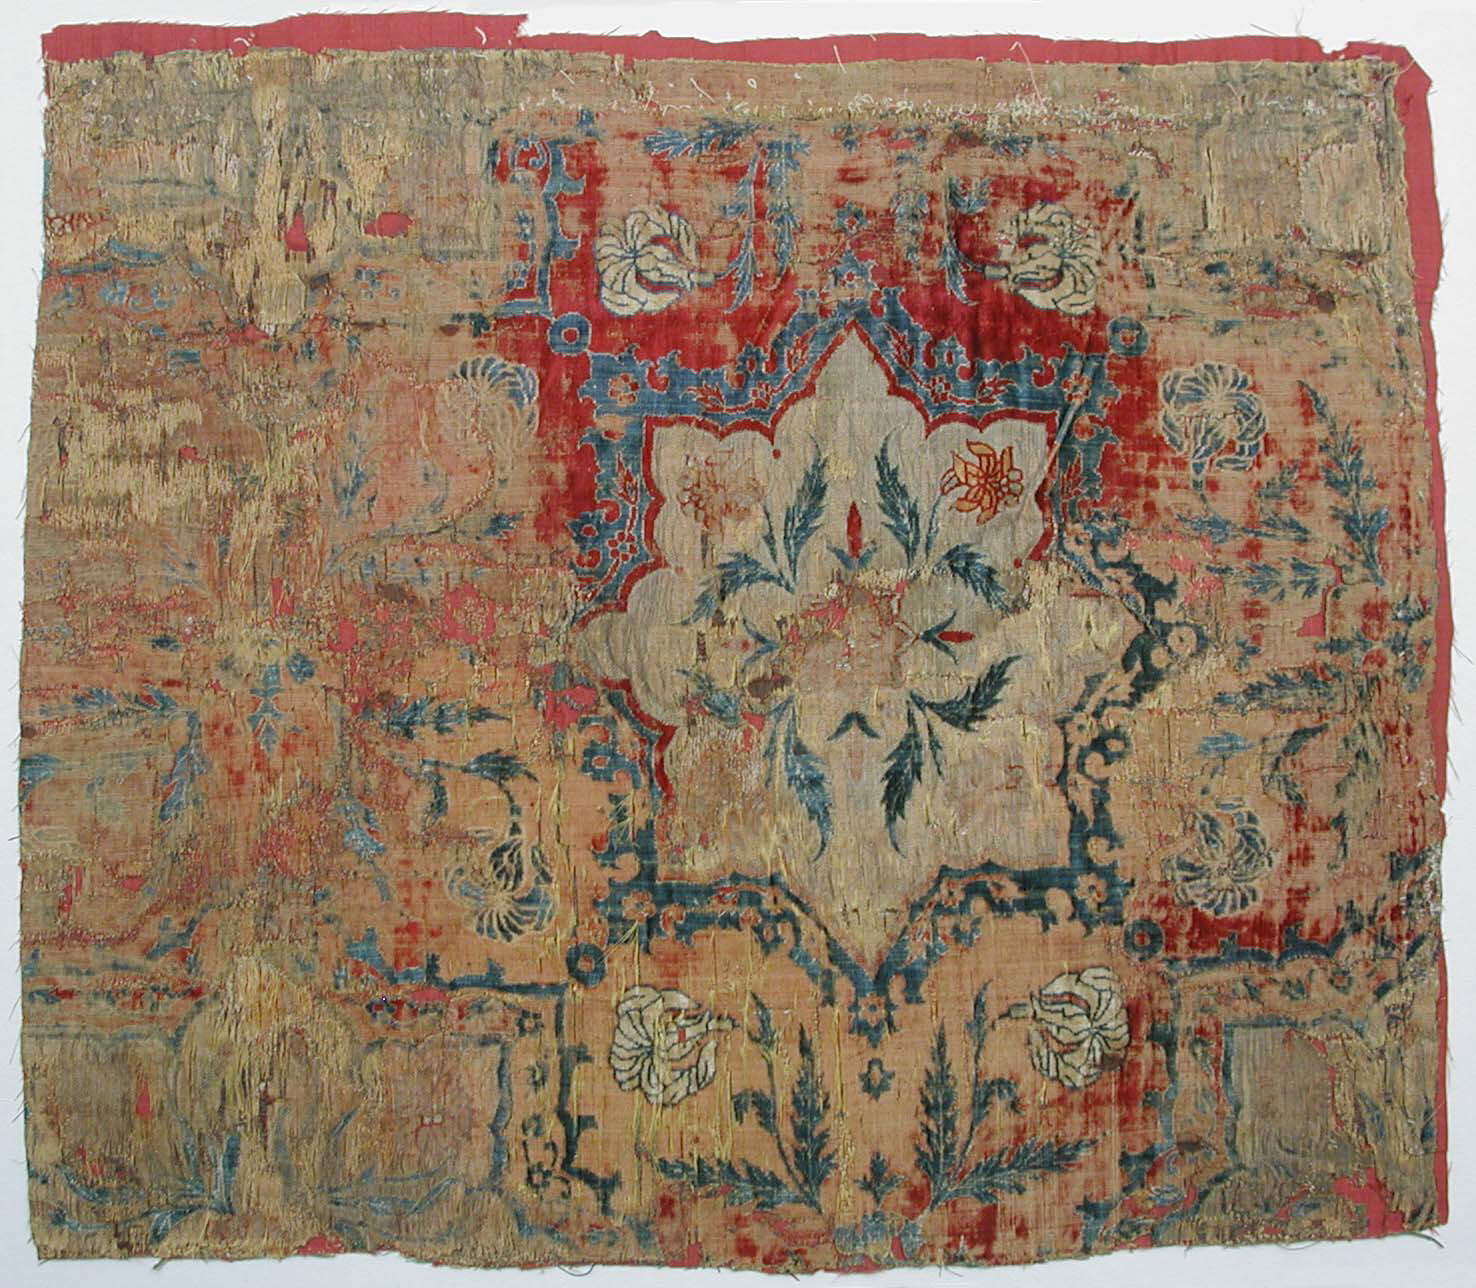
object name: textile fragment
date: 1601-1650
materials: metal, silk, velvet, thread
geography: india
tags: flowers